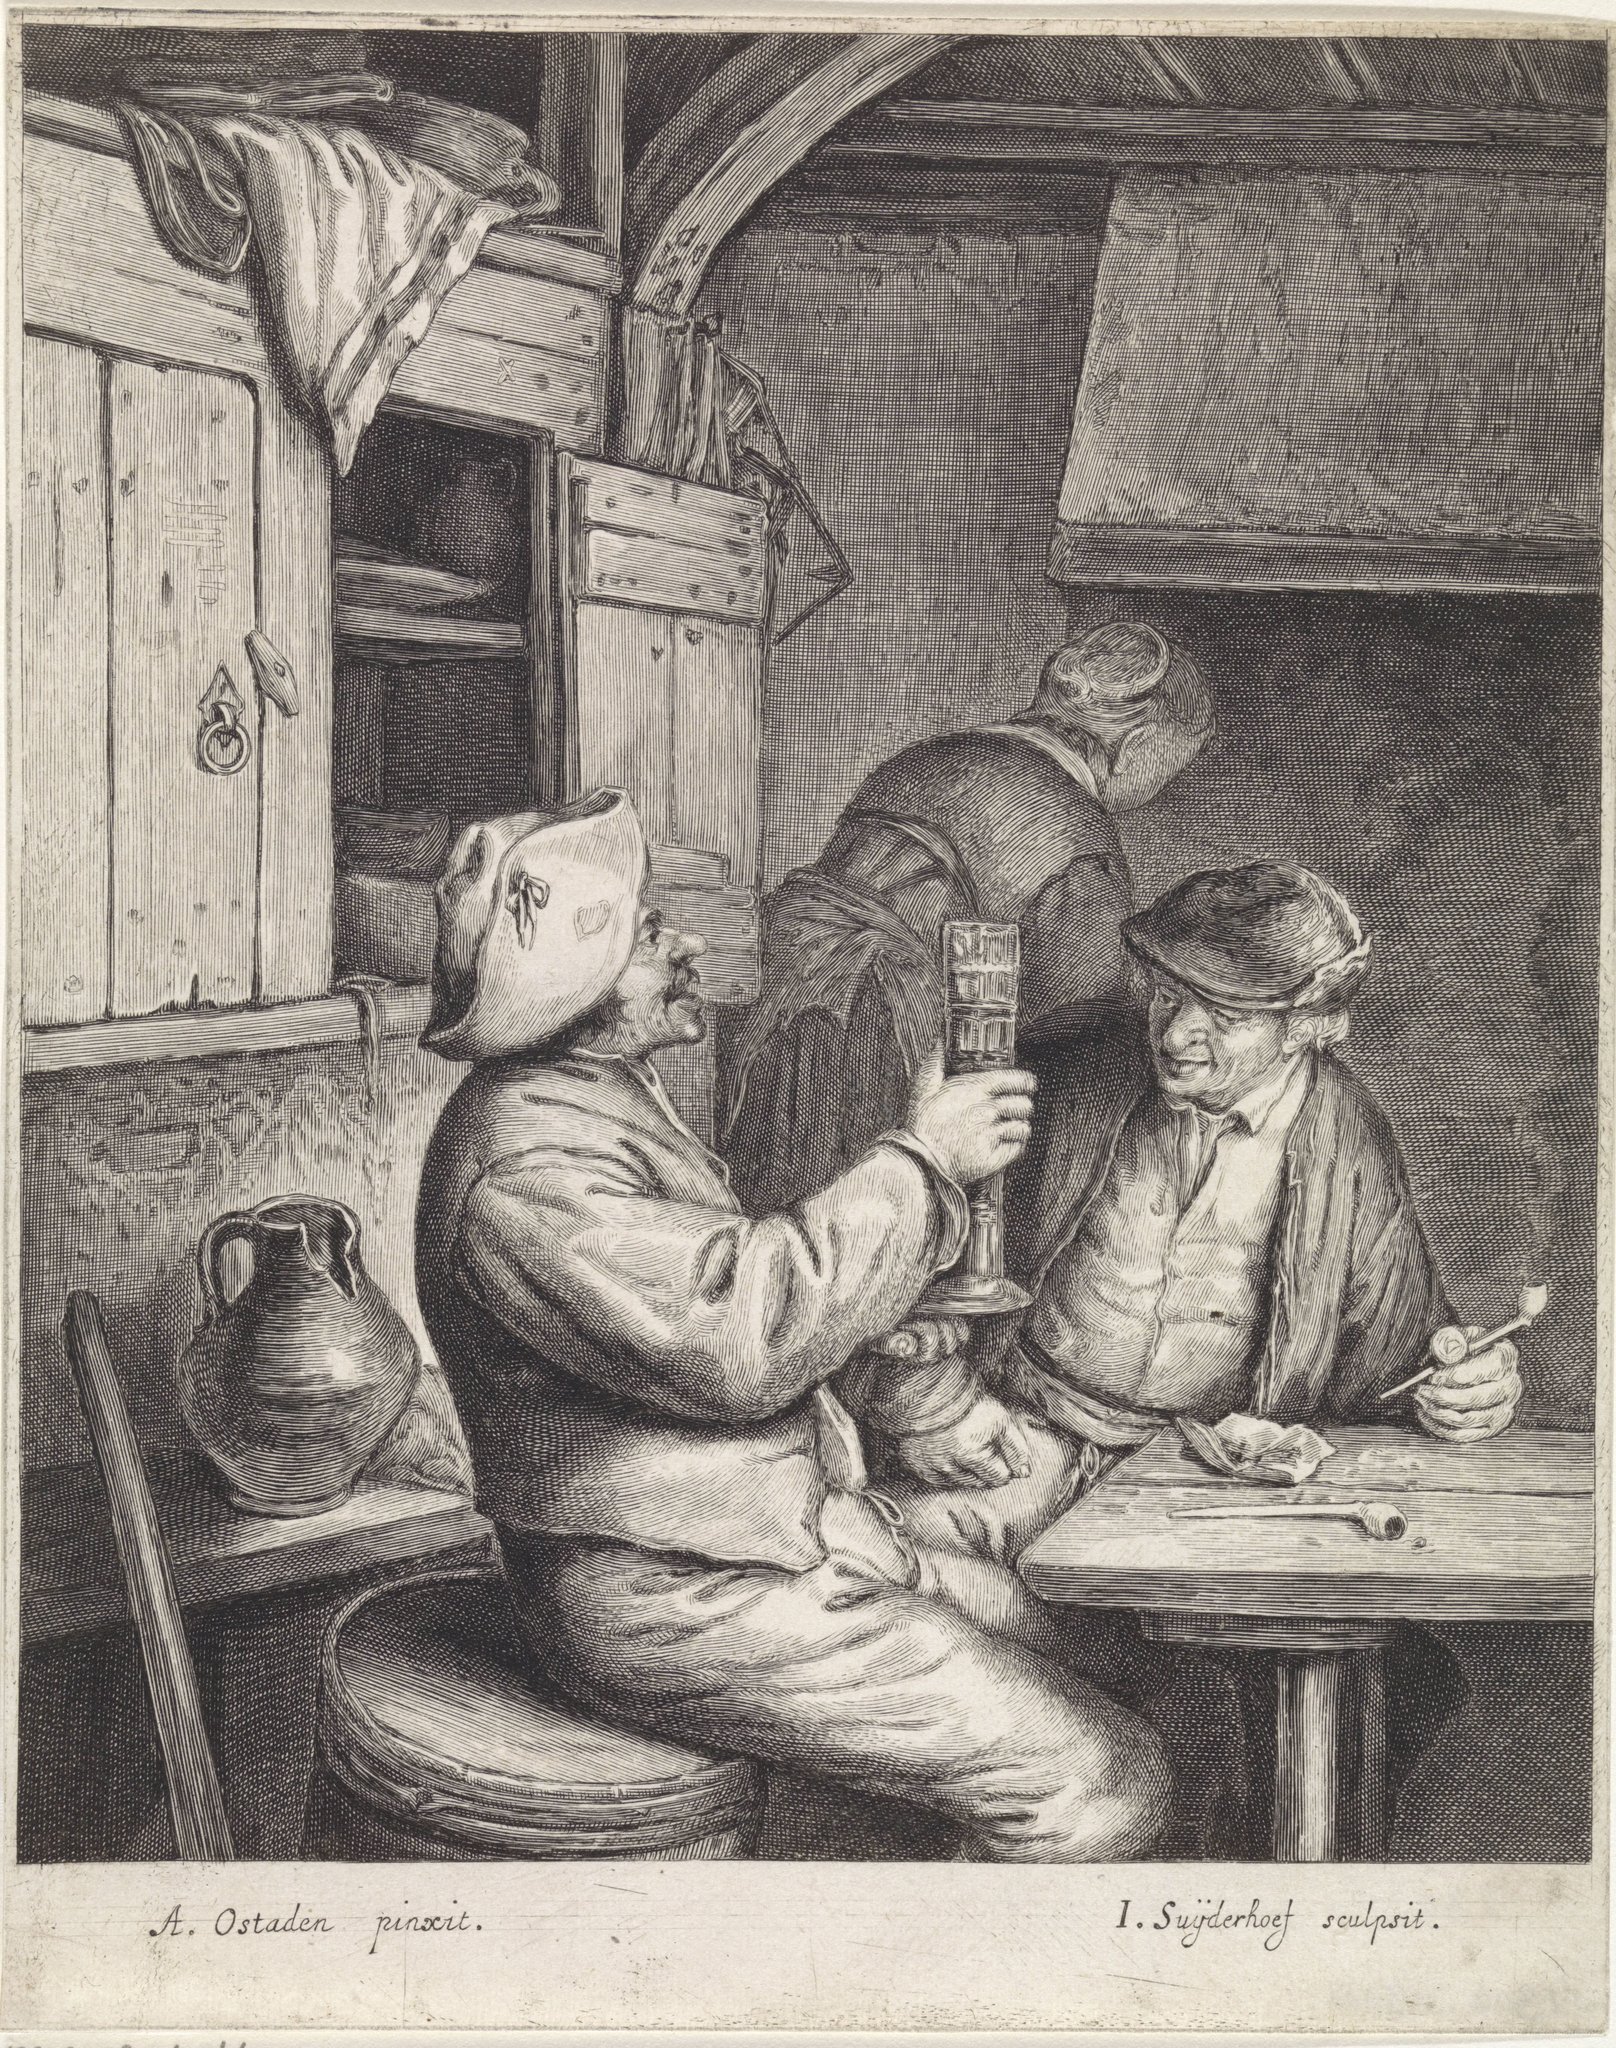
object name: print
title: Twee boeren zittend aan een tafel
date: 1623-1686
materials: paper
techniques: engraving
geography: haarlem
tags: pipe ~ tobacco, glass, rummer, cupboard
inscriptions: collector's mark: Lugt 240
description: Twee boeren zitten aan een tafel. De een heft een glas, de ander houdt een pijp in de hand. Op de achtergrond een vrouw op de rug gezien.